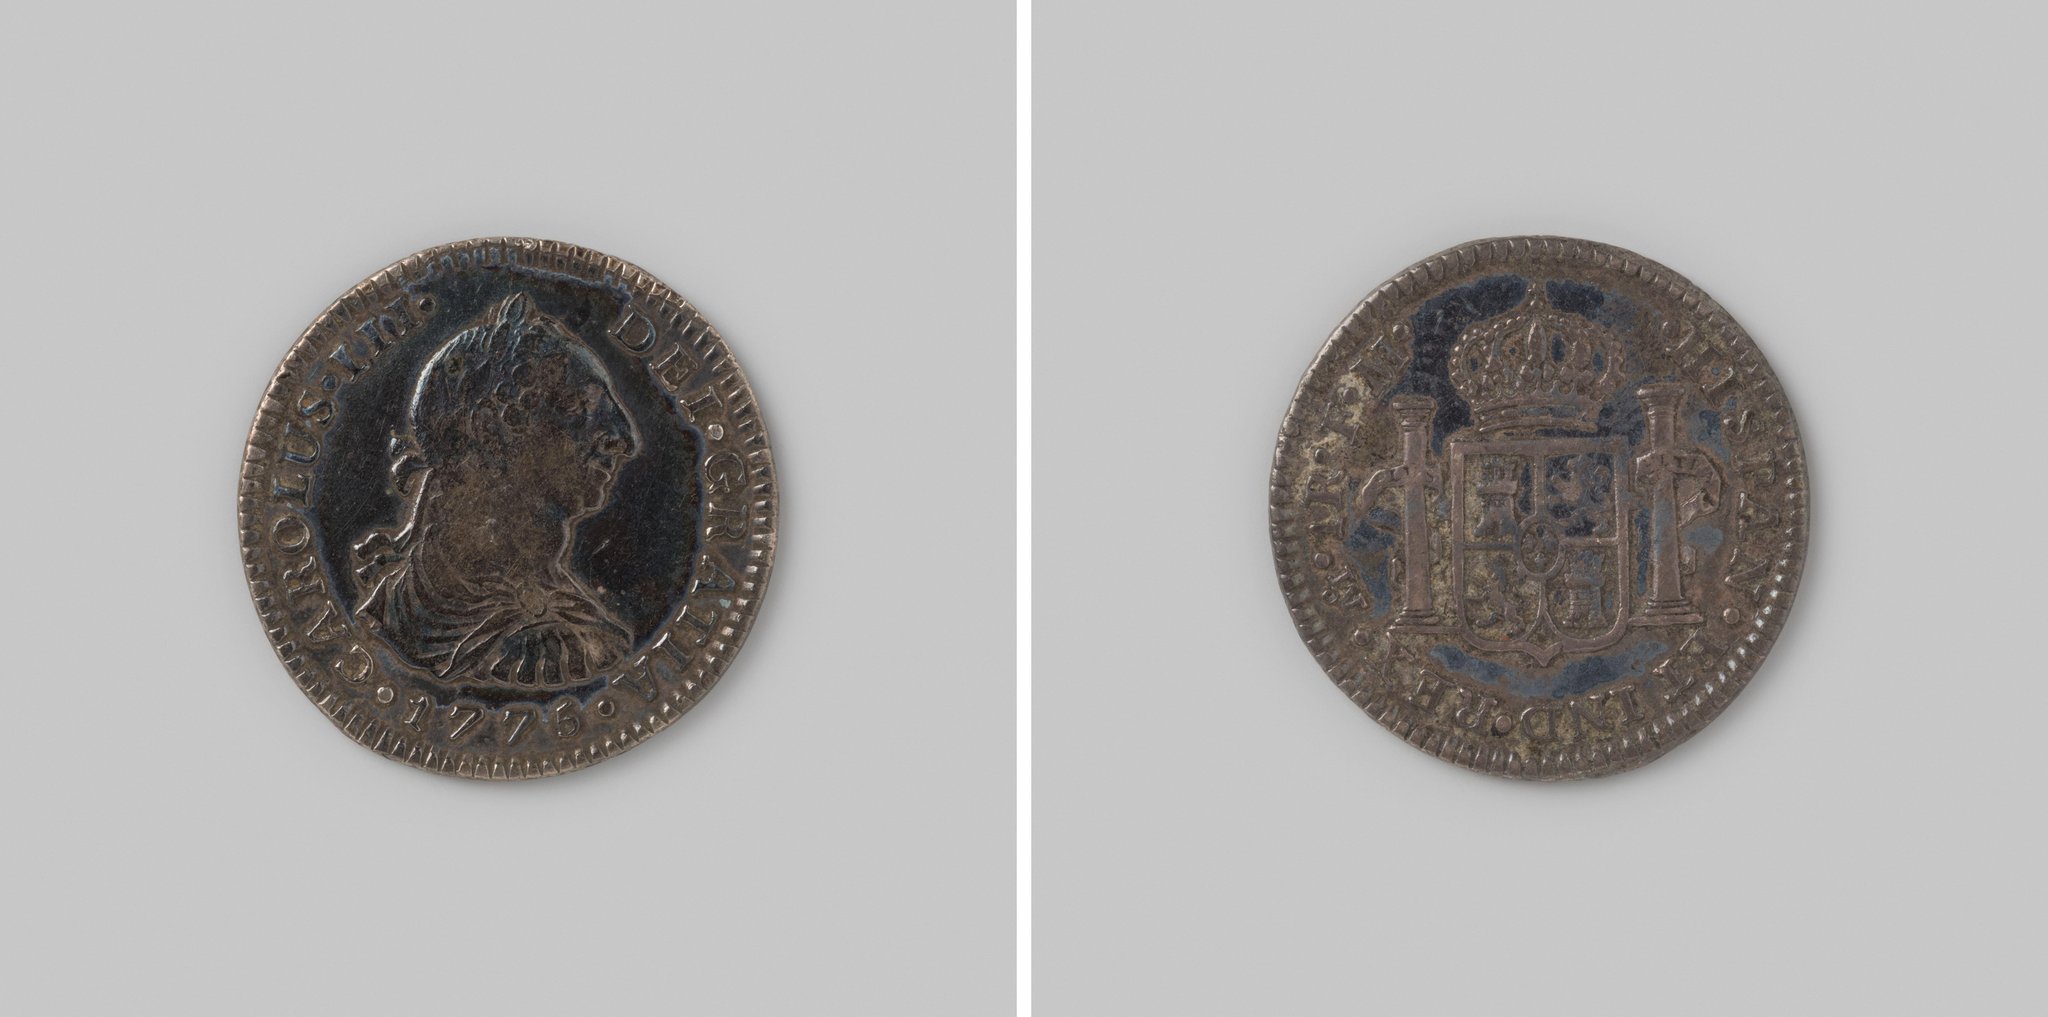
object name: real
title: Mexico, koning Karel III, reaal,1775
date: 1775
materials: silver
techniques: striking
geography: mexico city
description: Zilveren munt. Voorzijde: gelauwerd hoofd van de koning naar rechts. Jaartal onderaan. Keerzijde: tussen twee uit zee oprijzende zuilen, waarop banderol met opschrift, gekroond samengesteld wapenschild. Muntplaats-aanduiding: Mo. en waarde-aanduiding: 1R in omschrift. Versierde rand.